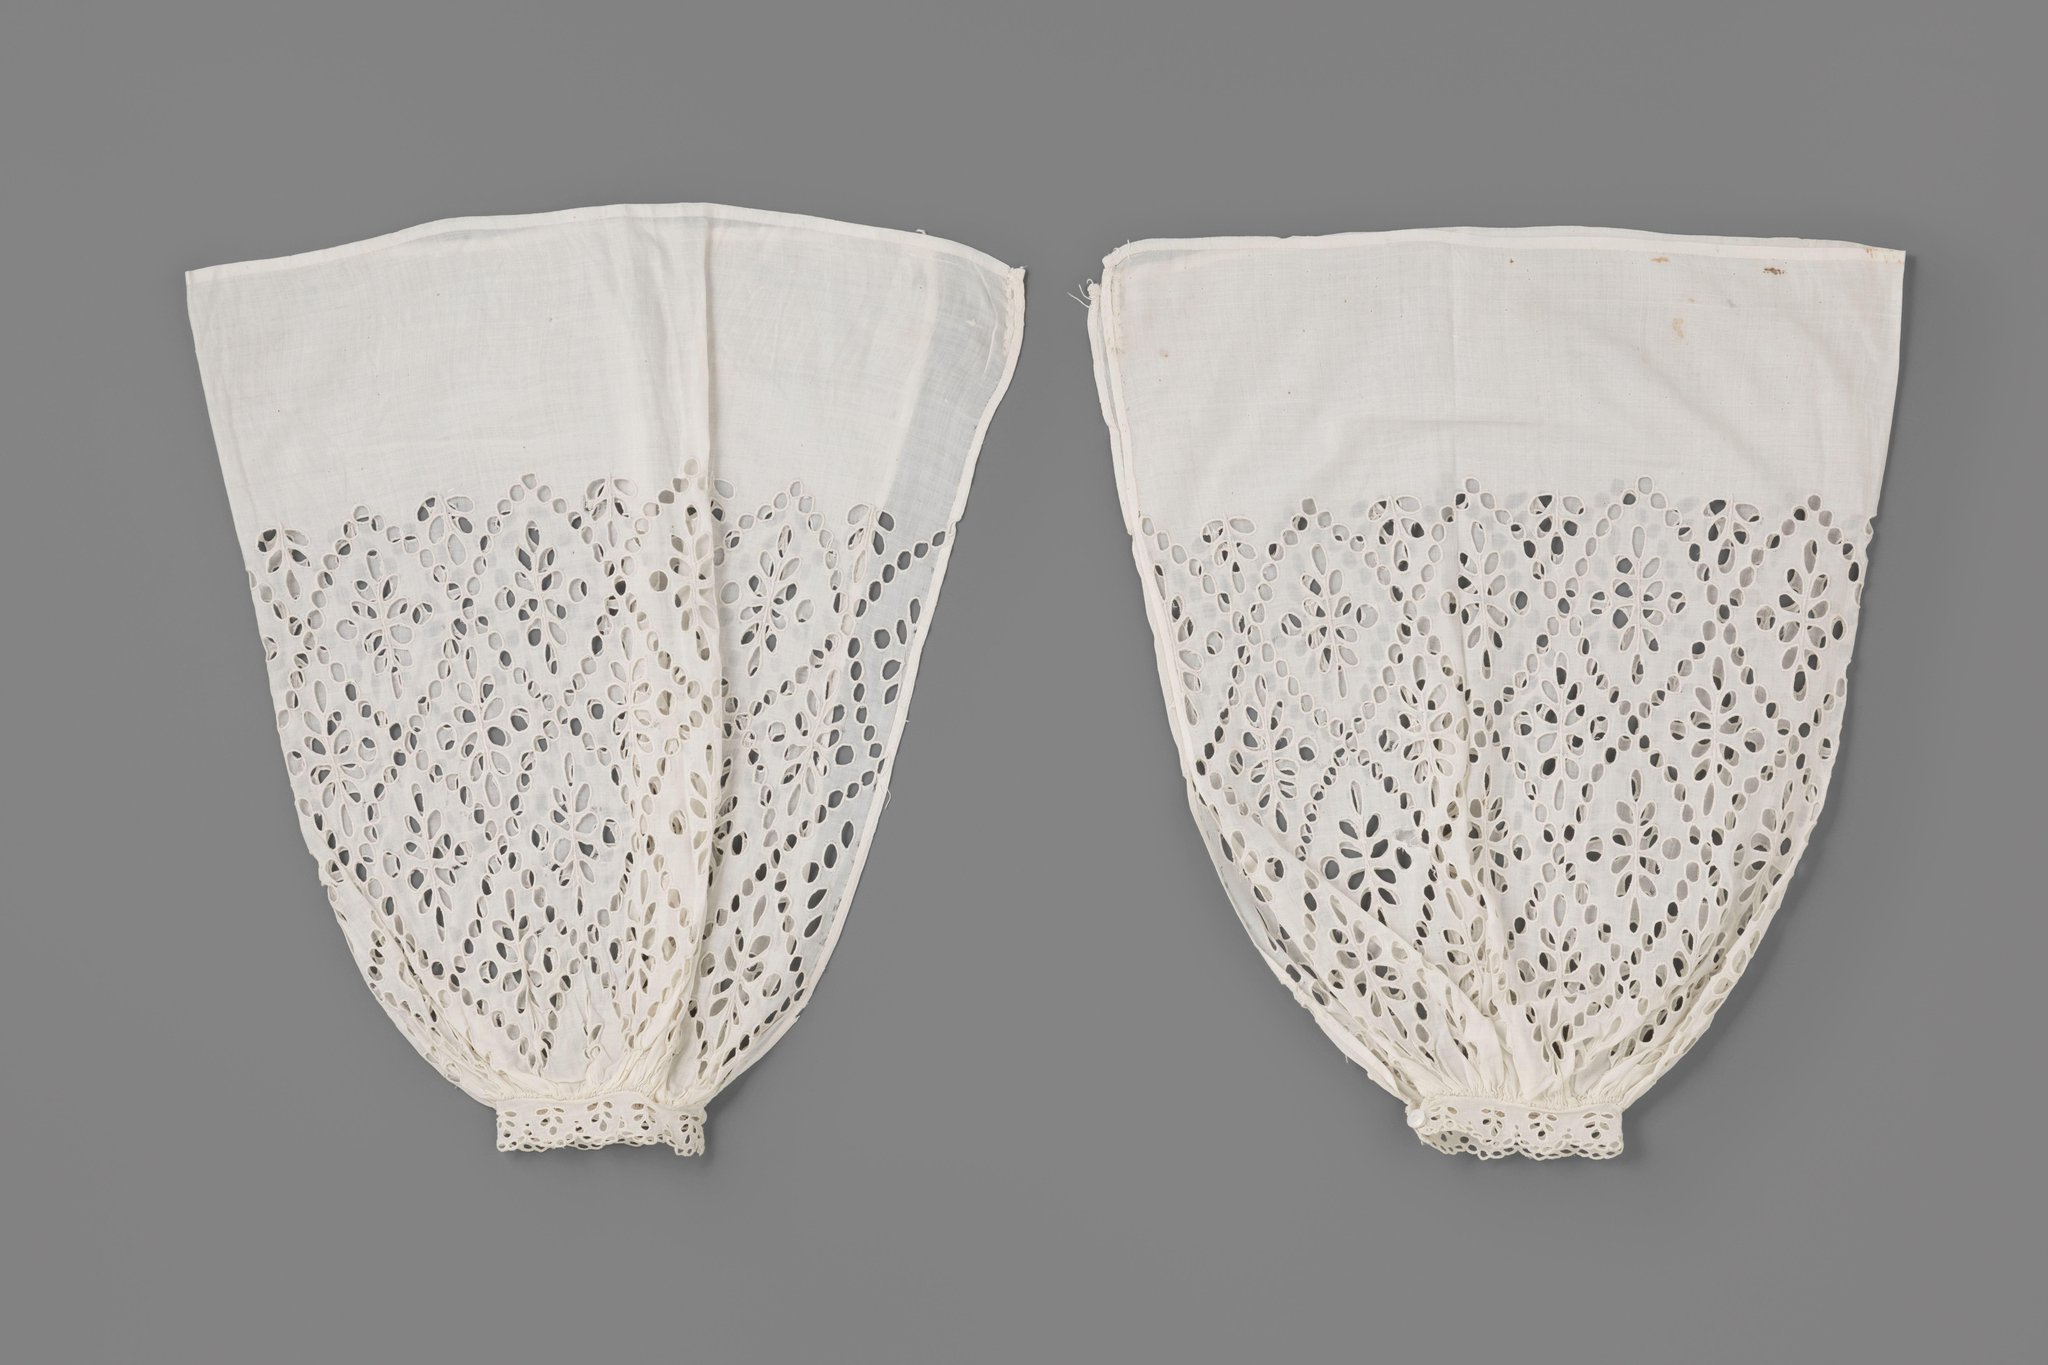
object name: undersleeve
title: Ondermouw van linnen batist, met Engels borduurwerk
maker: Anonymous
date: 1865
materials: textile, glass, linen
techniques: english embroidery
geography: western europe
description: Ondermouw van linnen batist. De mouw is versierd met Engels borduurwerk in de vorm van een ruitpatroon waarin symmetrische motieven. Ook de manchet, waar de mouw gerimpeld aan is bevestigd, is met Engels borduurwerk versierd. Met knoop van glas.